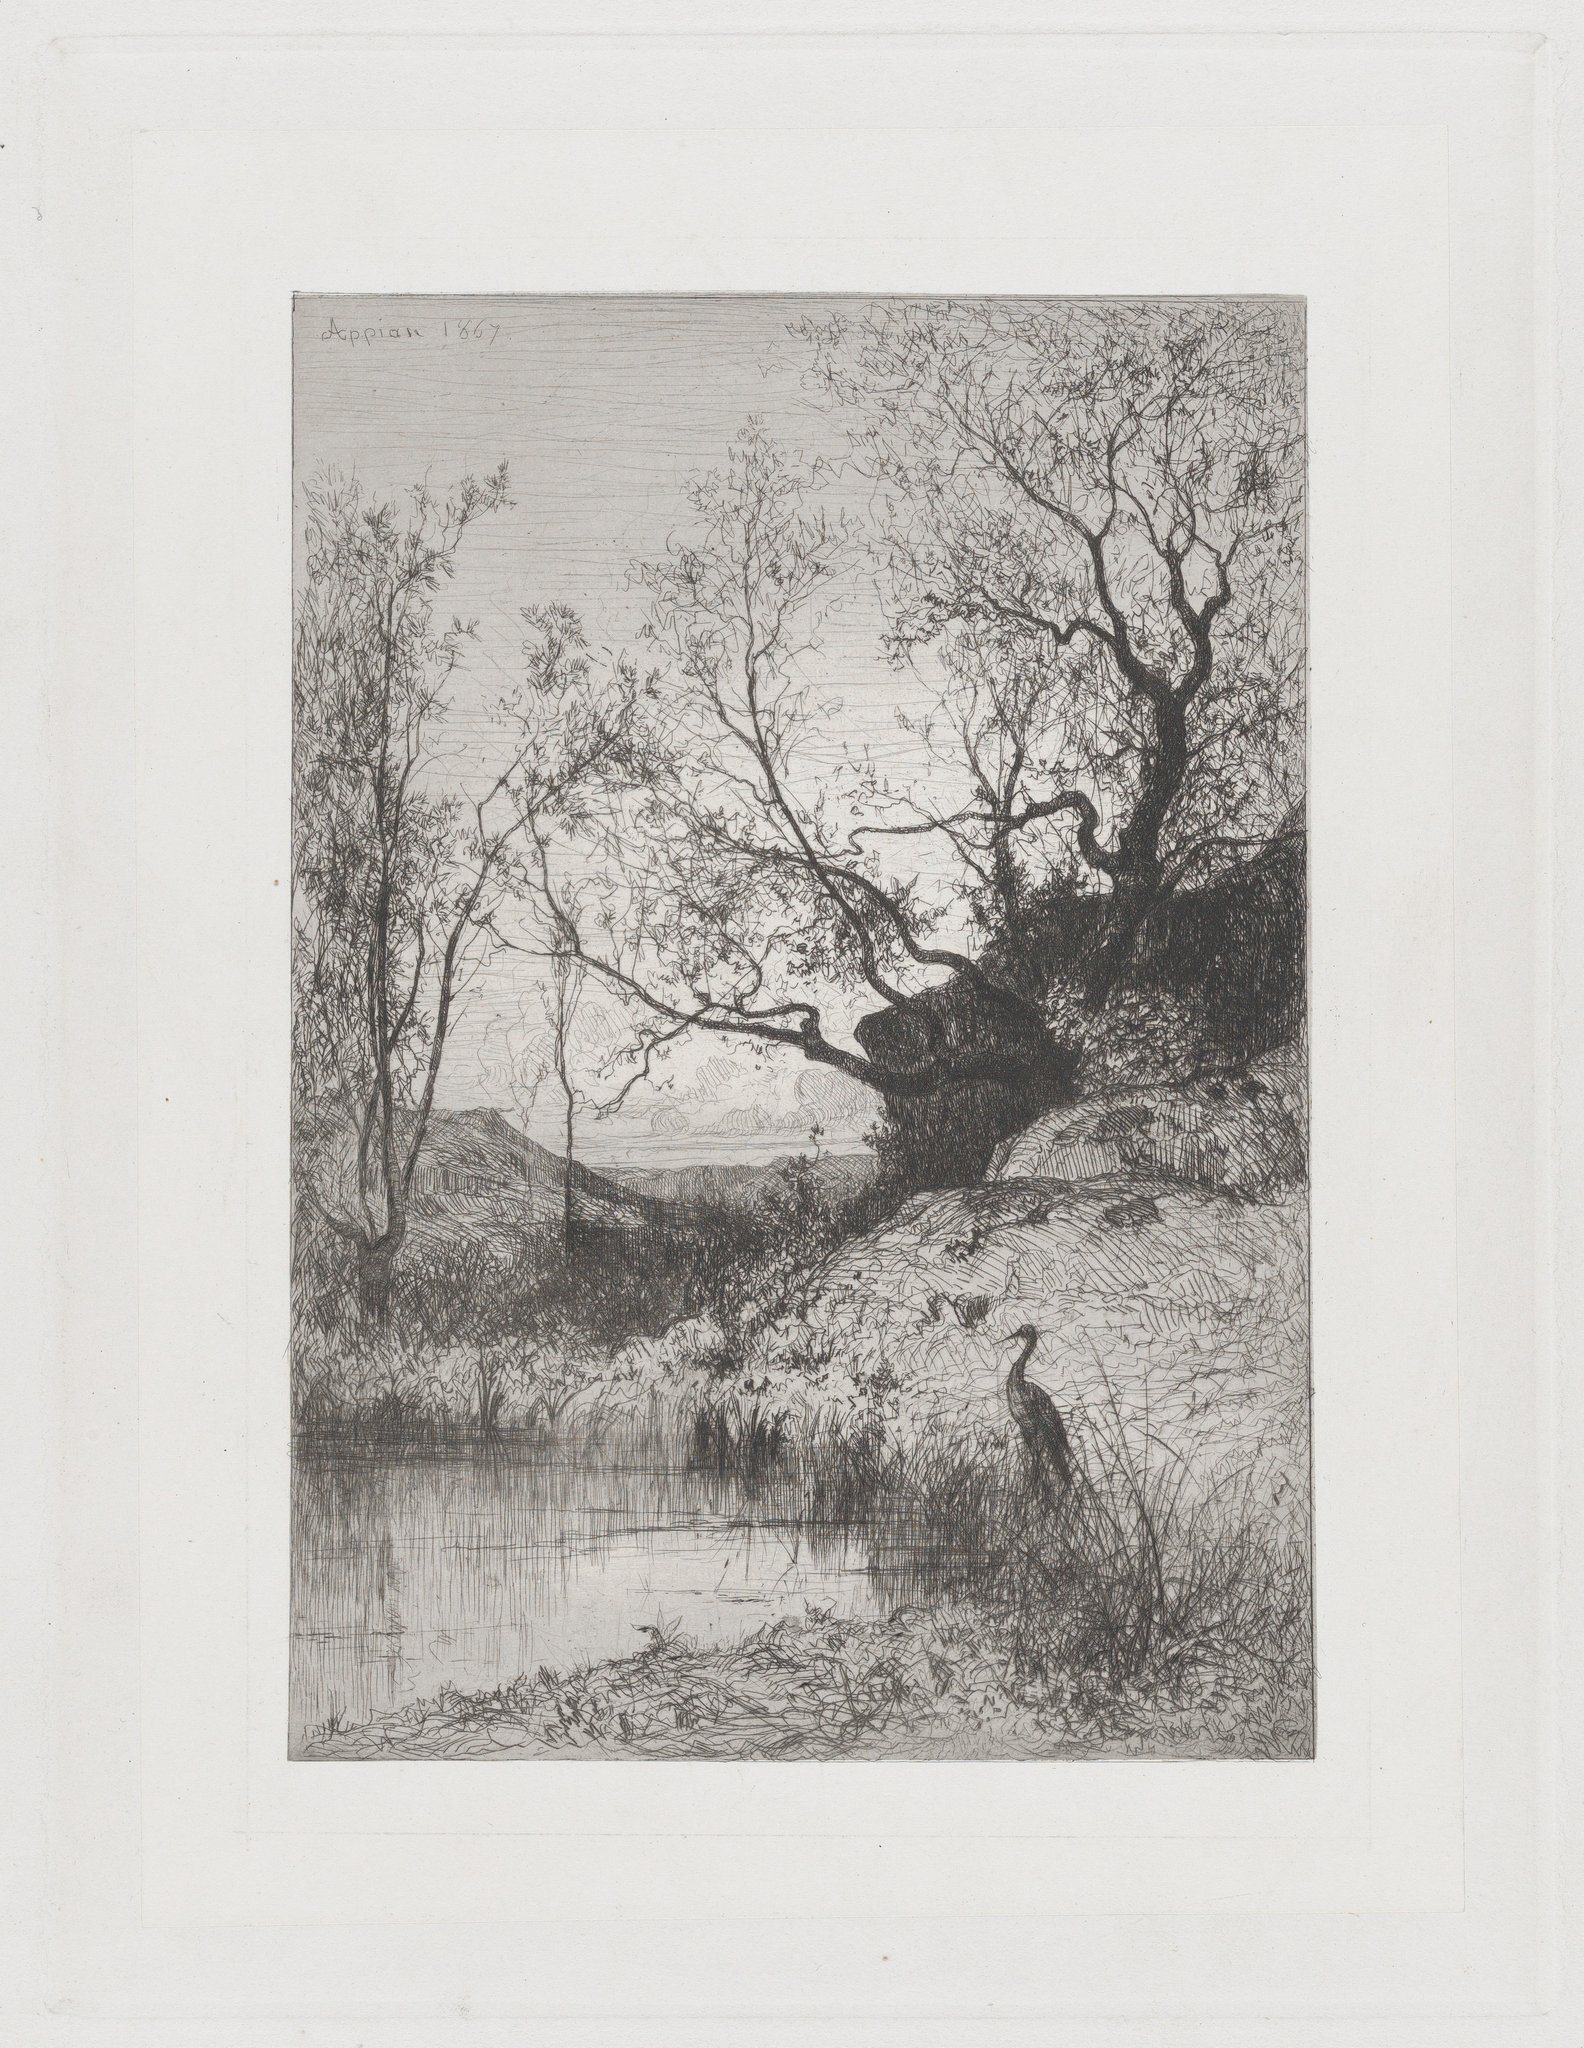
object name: print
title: A Pond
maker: adolphe appian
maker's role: artist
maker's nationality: french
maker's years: 1818-1898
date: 1867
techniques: etching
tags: birds,ponds,landscapes